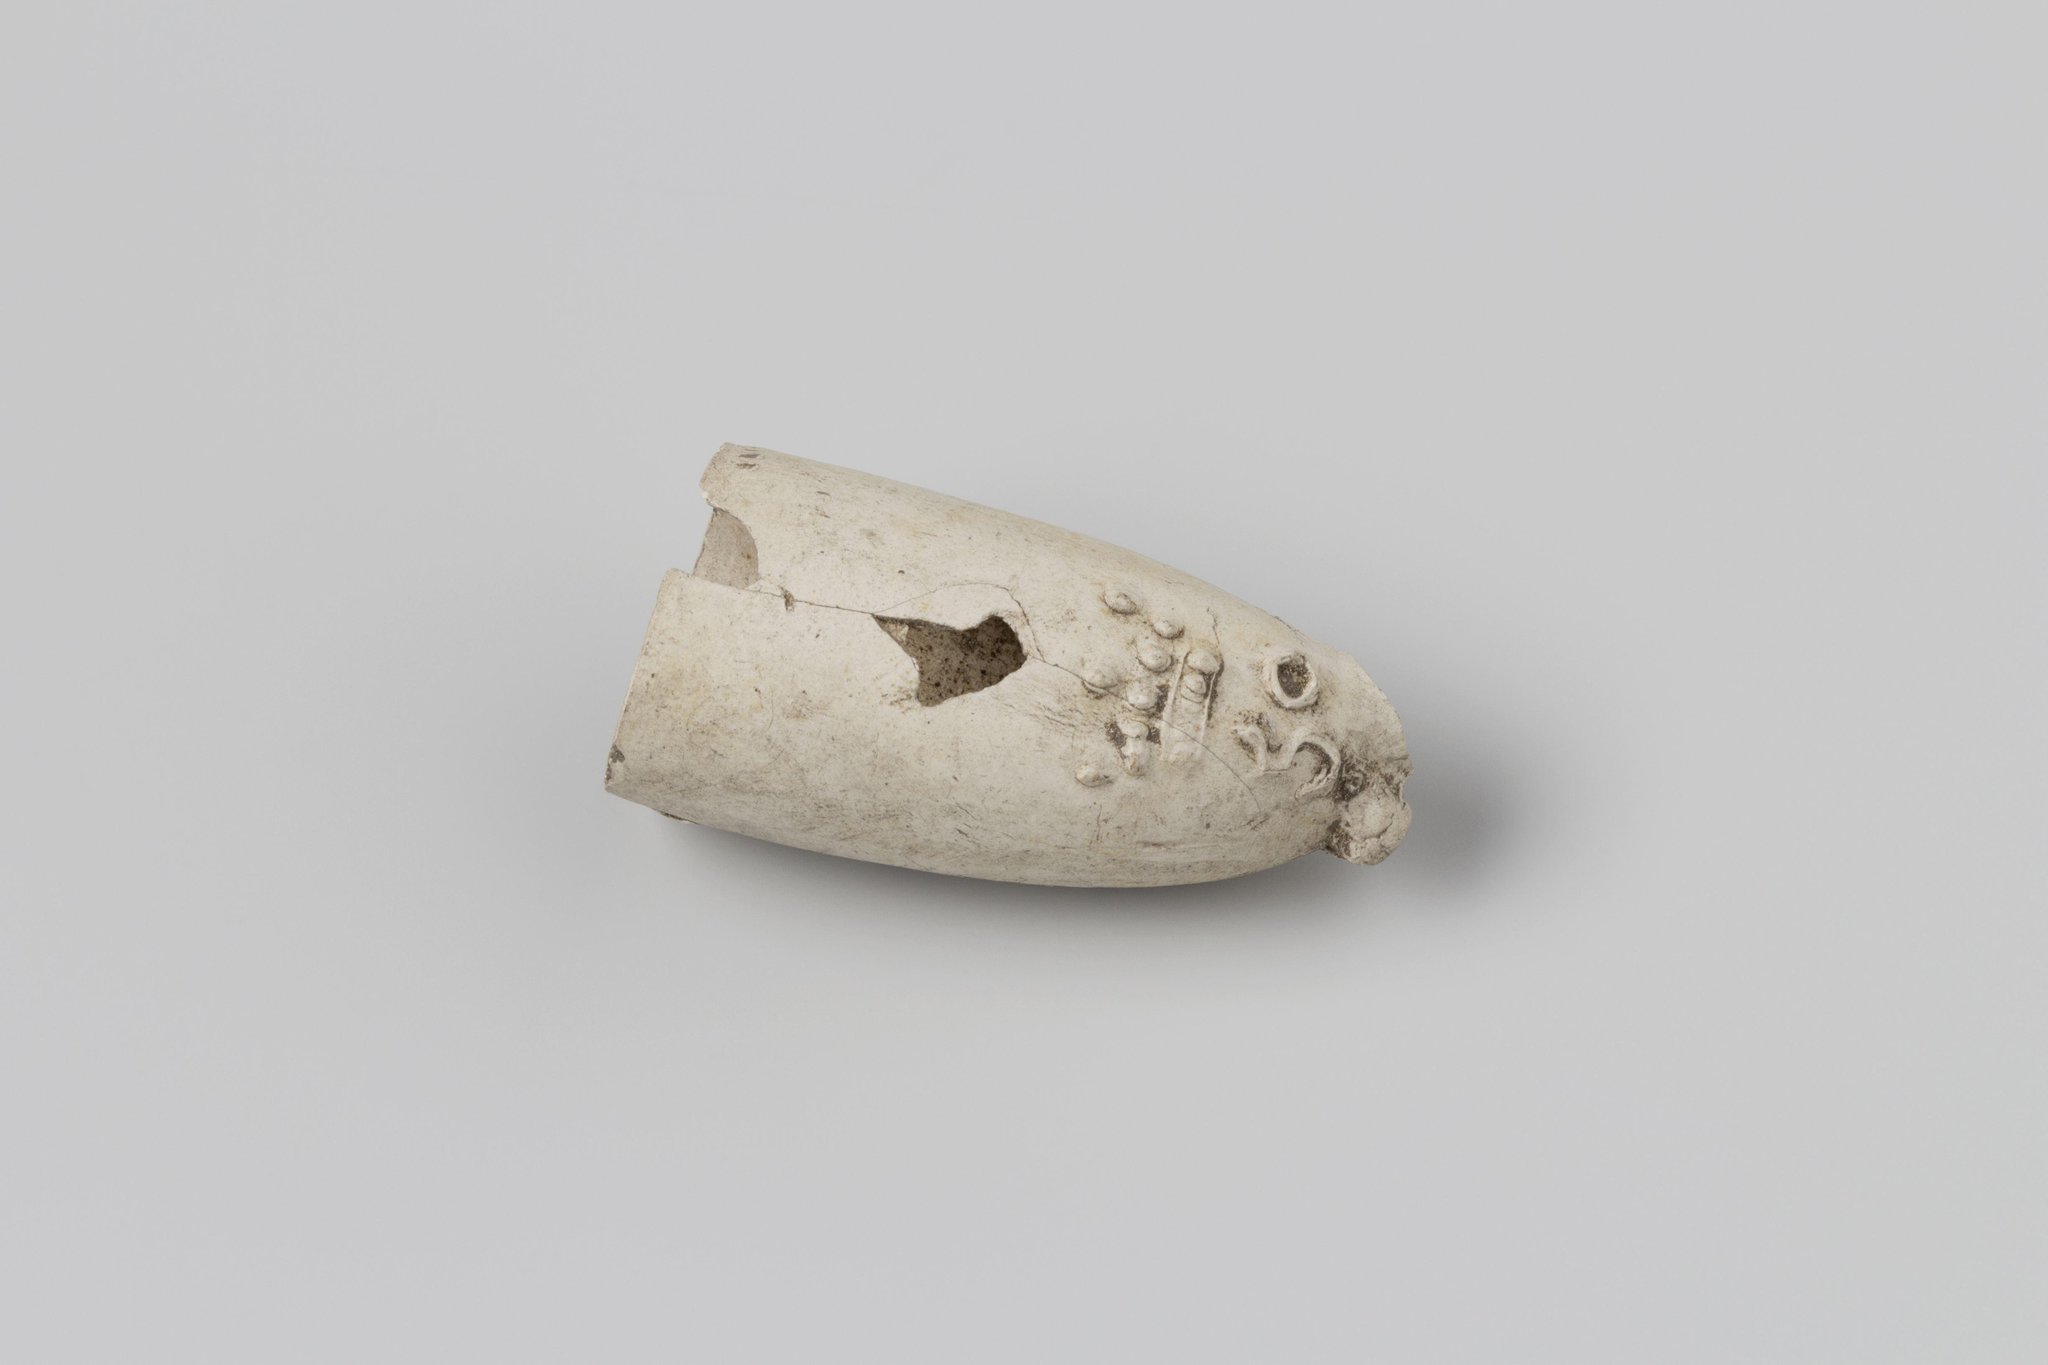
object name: pipe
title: Fragment pijpenkop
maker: Anonymous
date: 1750-1780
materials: clay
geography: gouda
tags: the hague, rotterdam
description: Fragment pijpenkop met een kroon en het getal 50 afgebeeld. Van de opgravingen op de Hofstede Arentsburg 1827-1831 onder toezicht van Professor Reuvens.